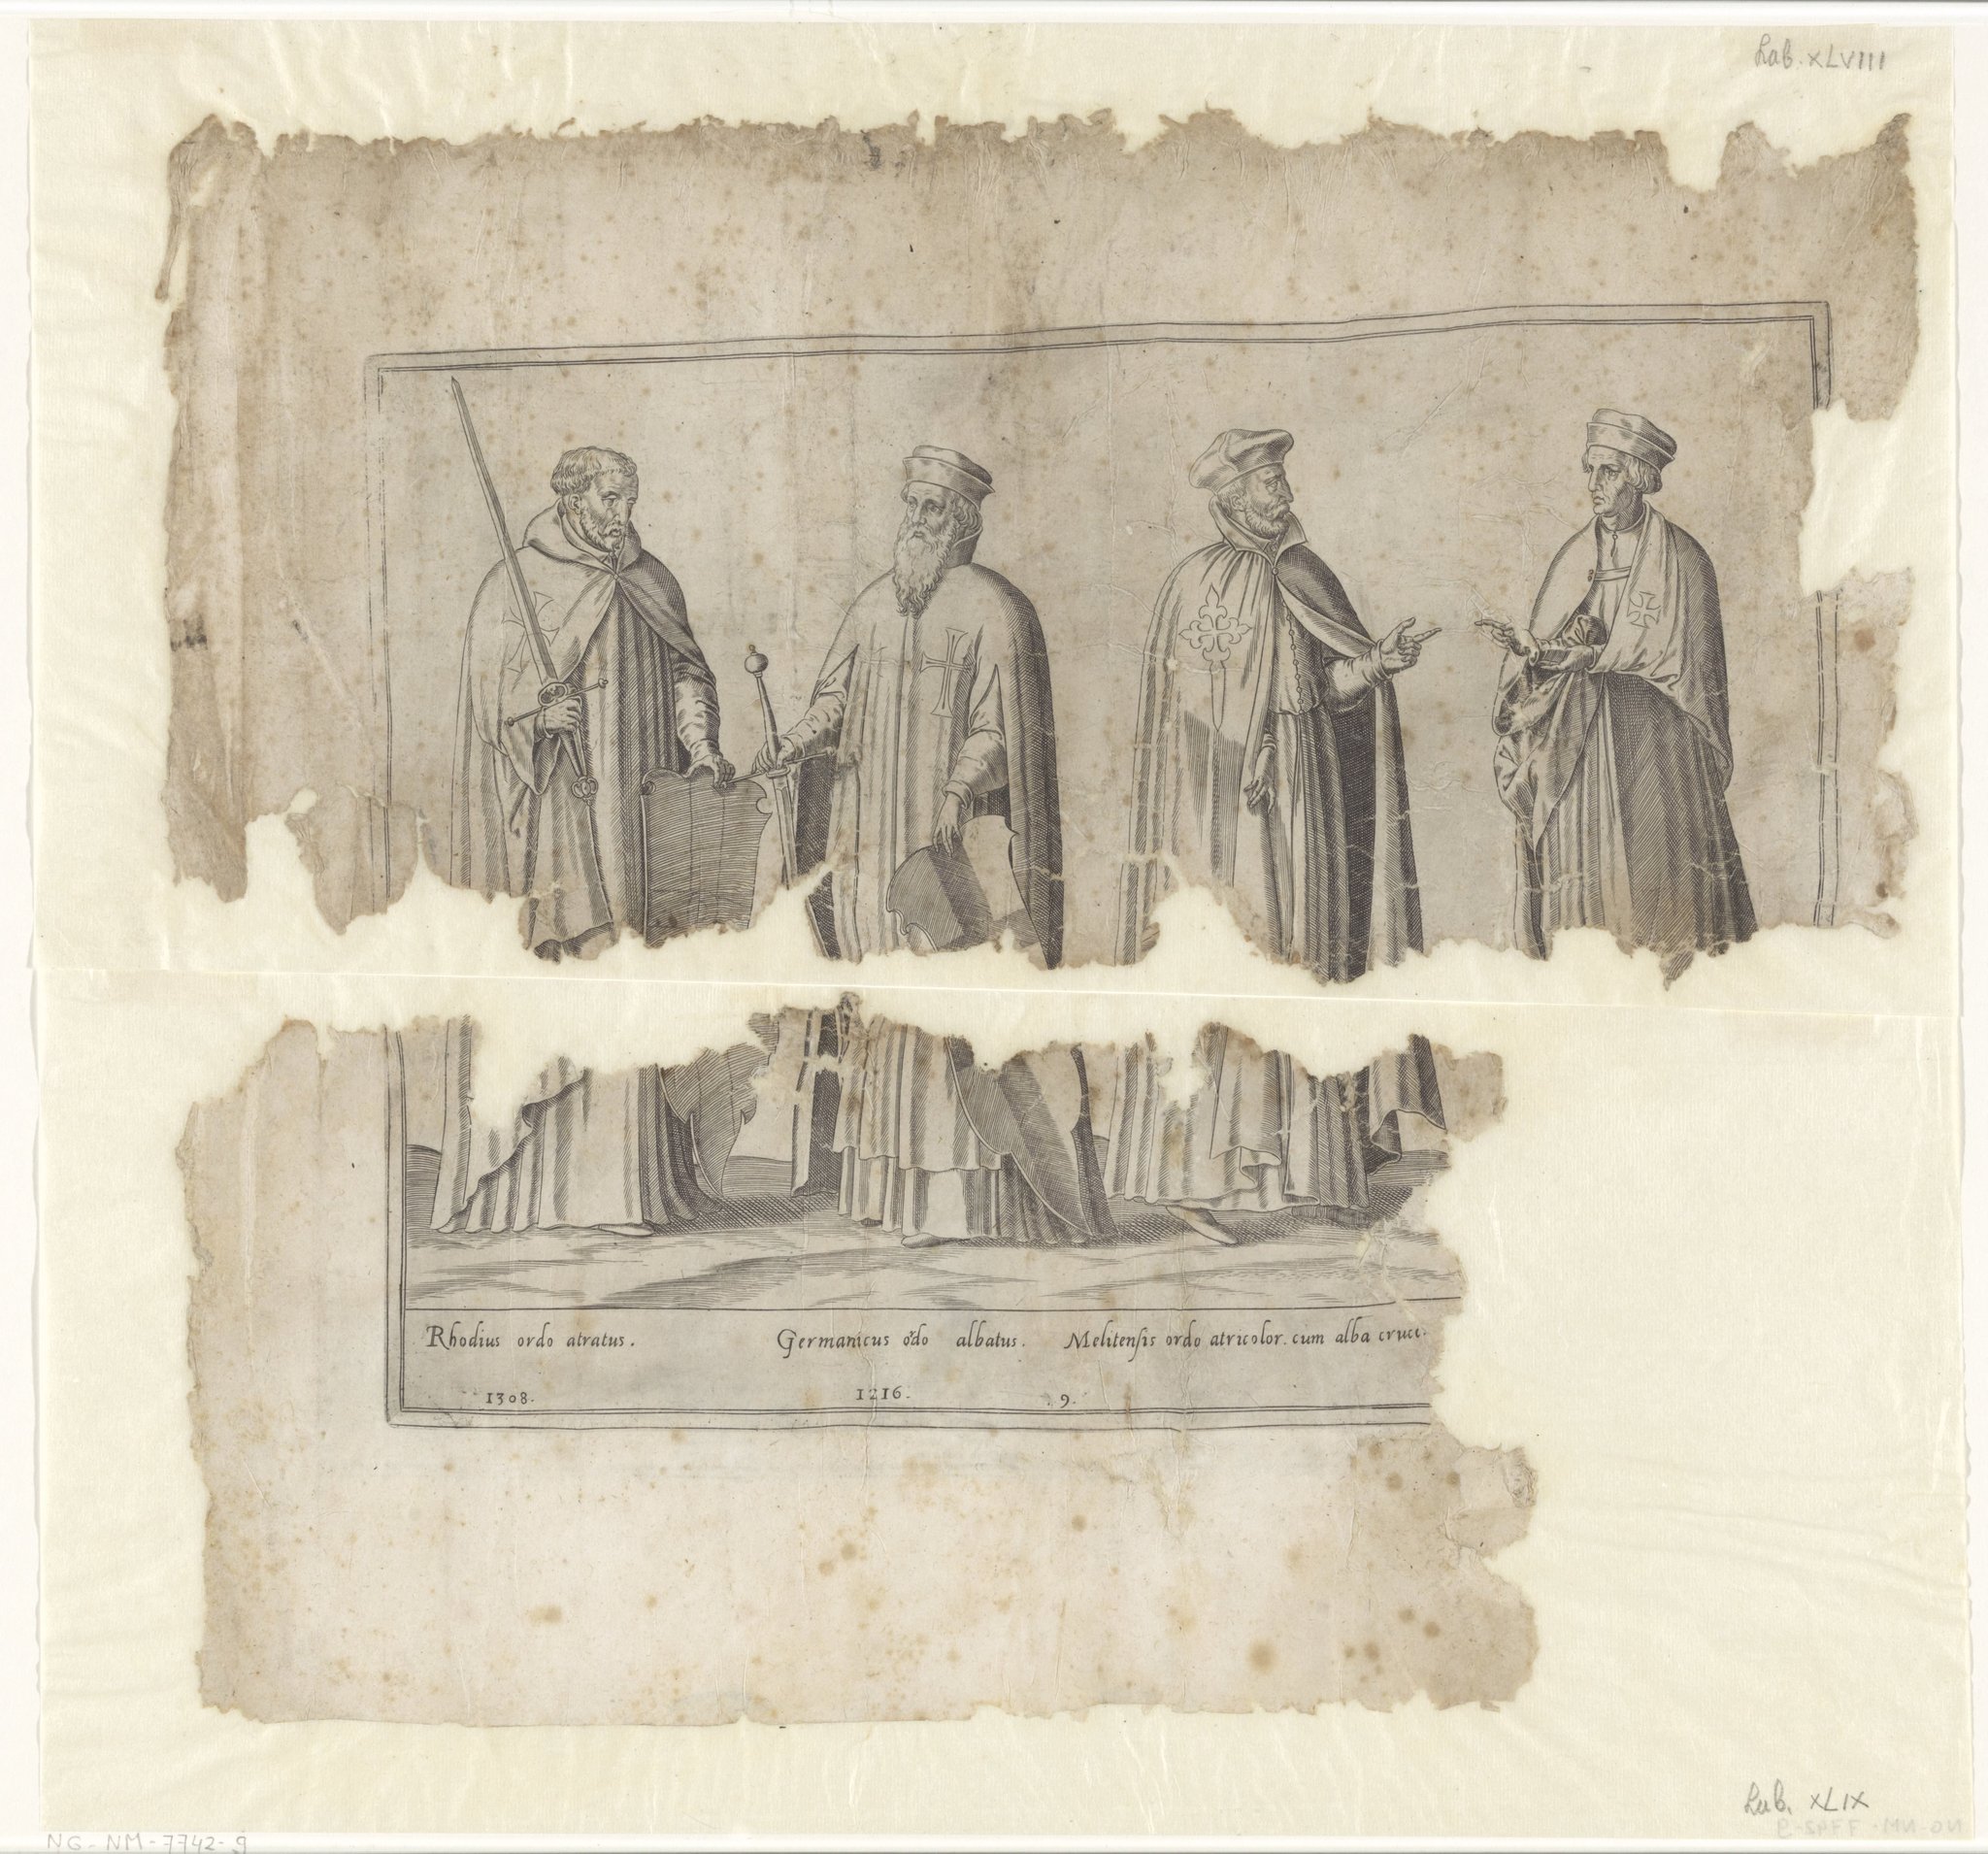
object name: print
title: Fragmenten van prenten met wereldlijke en geestelijke klederdrachten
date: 1581-1596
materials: paper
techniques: engraving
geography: cologne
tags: clothes, costume (+ women's clothes), clothes, costume (+ men's clothes)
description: De prenten in de Nova Zembla collectie zijn tijdens een expeditie van Willem Barendsz en Jacob van Heemskerk in 1596-1597 noodgedwongen in het winterkamp, het ‘Behouden Huis’, op het eiland achtergelaten. De prenten waren in één of meerdere stapels als handelswaar meegenomen vanuit Amsterdam. Bijna drie eeuwen later, in 1871, keerde de Noor Elling Carlsen terug naar Nova Zembla en vond daar de restanten van het ‘Behouden Huis, inclusief een groot deel van de inventaris. Een deel van de prenten, in de vorm van aaneengekoekte kluiten, werd toen ook teruggevonden. De papierkluiten waren soms op meerdere plekken gebroken. Tussen 1975-1979 zijn de prenten van elkaar gescheiden. Dit leverde in totaal ca. 1000 fragmenten van ca. 400 afdrukken van ca. 150 verschillende prenten op. Voor zover mogelijk zijn de fragmenten samengevoegd en zijn de prenten gereconstrueerd.